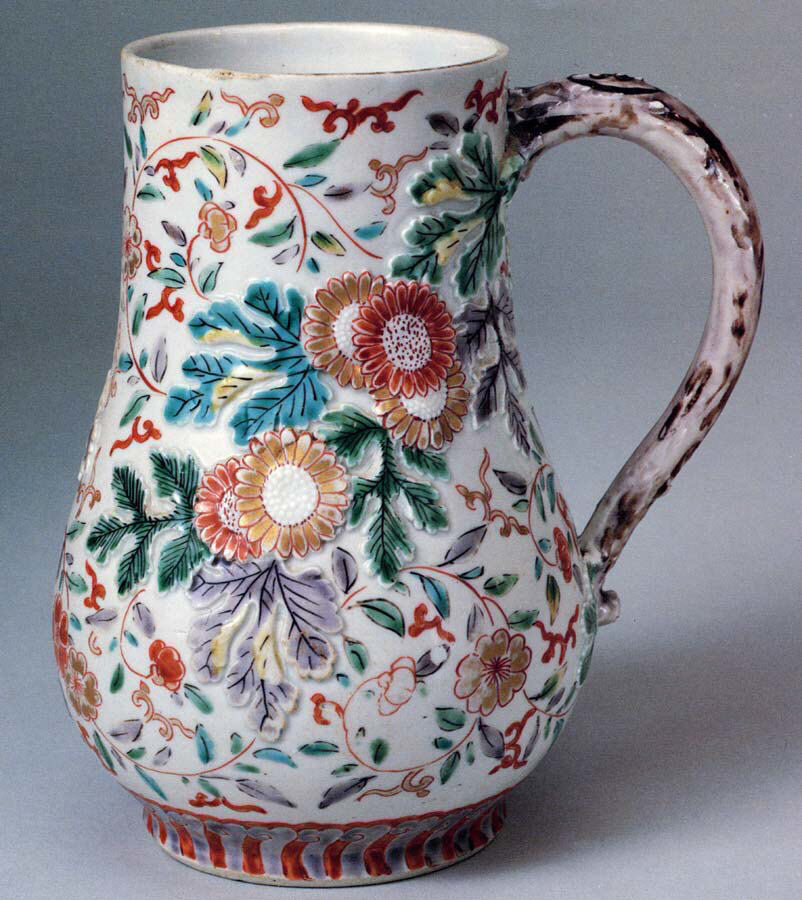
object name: tankard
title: Tankard in the Shape of a Pear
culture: japanese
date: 1667-1700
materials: enamel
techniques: overglaze, polychrome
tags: flowers